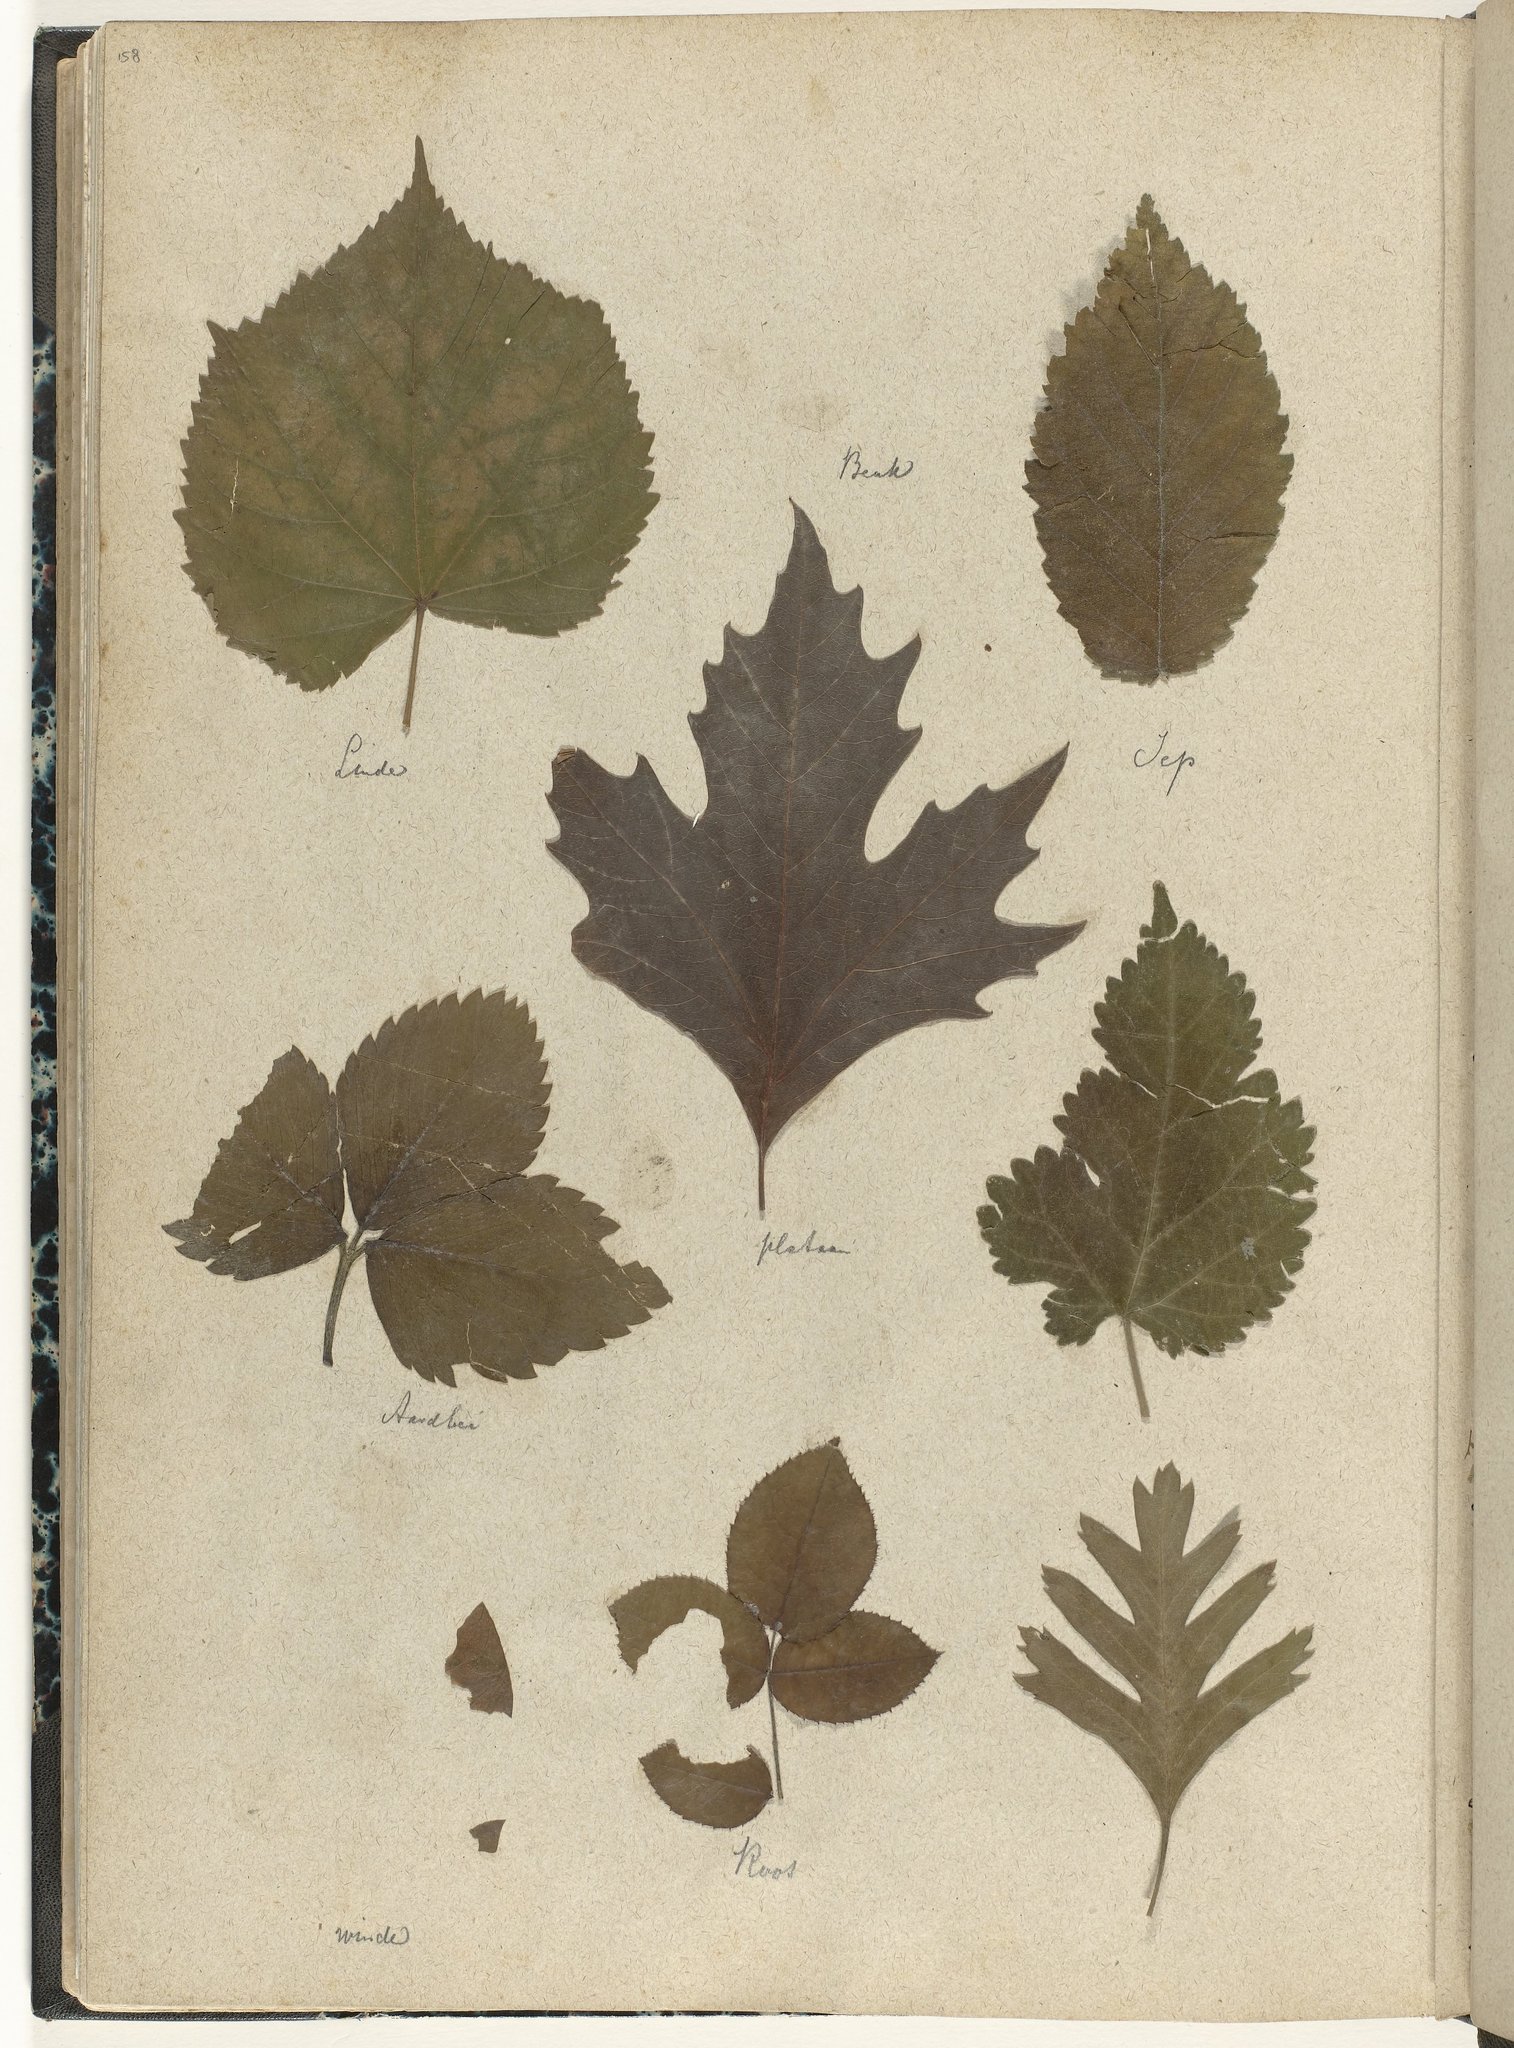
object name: album leaf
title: Bladeren van verschillende bomen en planten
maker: p.j. kool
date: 1866-1900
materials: leaf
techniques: printmaking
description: Opgeplakte bladeren afkomstig van onder andere linde, iep, aardbei, plataan en roos. Van de het windeblad linksonder zijn alleen nog fragmenten aanwezig. Onder de meeste bladeren staat met potlood geschreven van welke plant of boom ze afkomstig zijn.